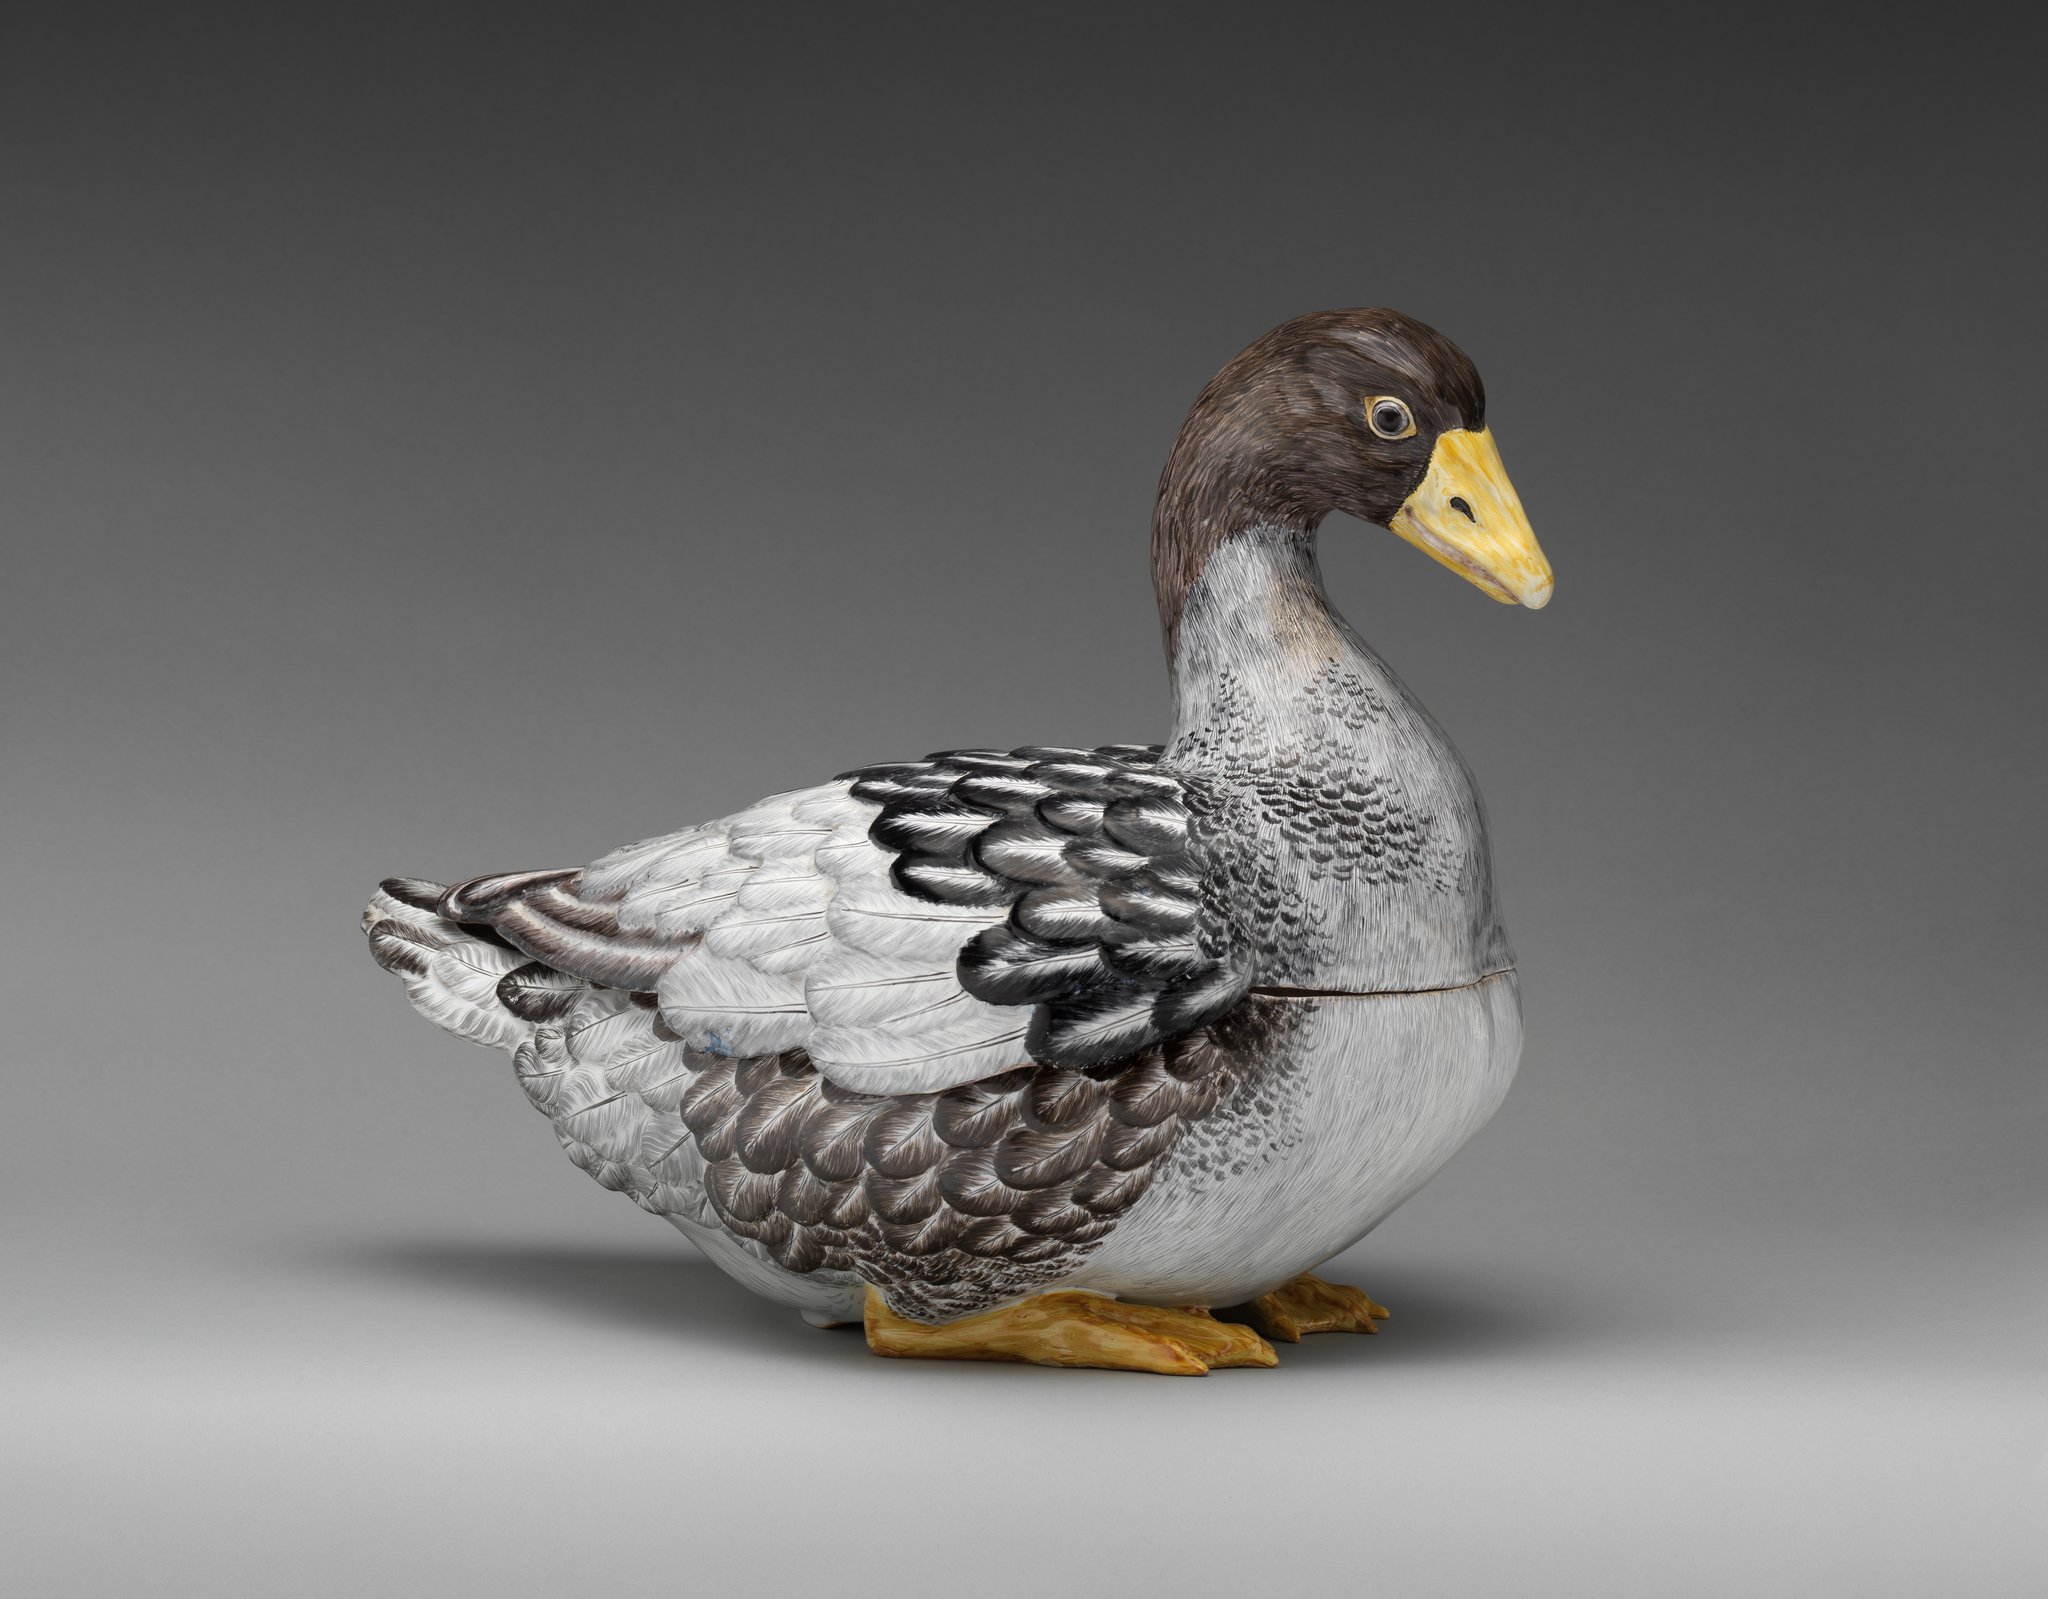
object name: tureen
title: Tureen in the form of a goose (one of a pair)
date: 1750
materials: faience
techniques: glazing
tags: birds